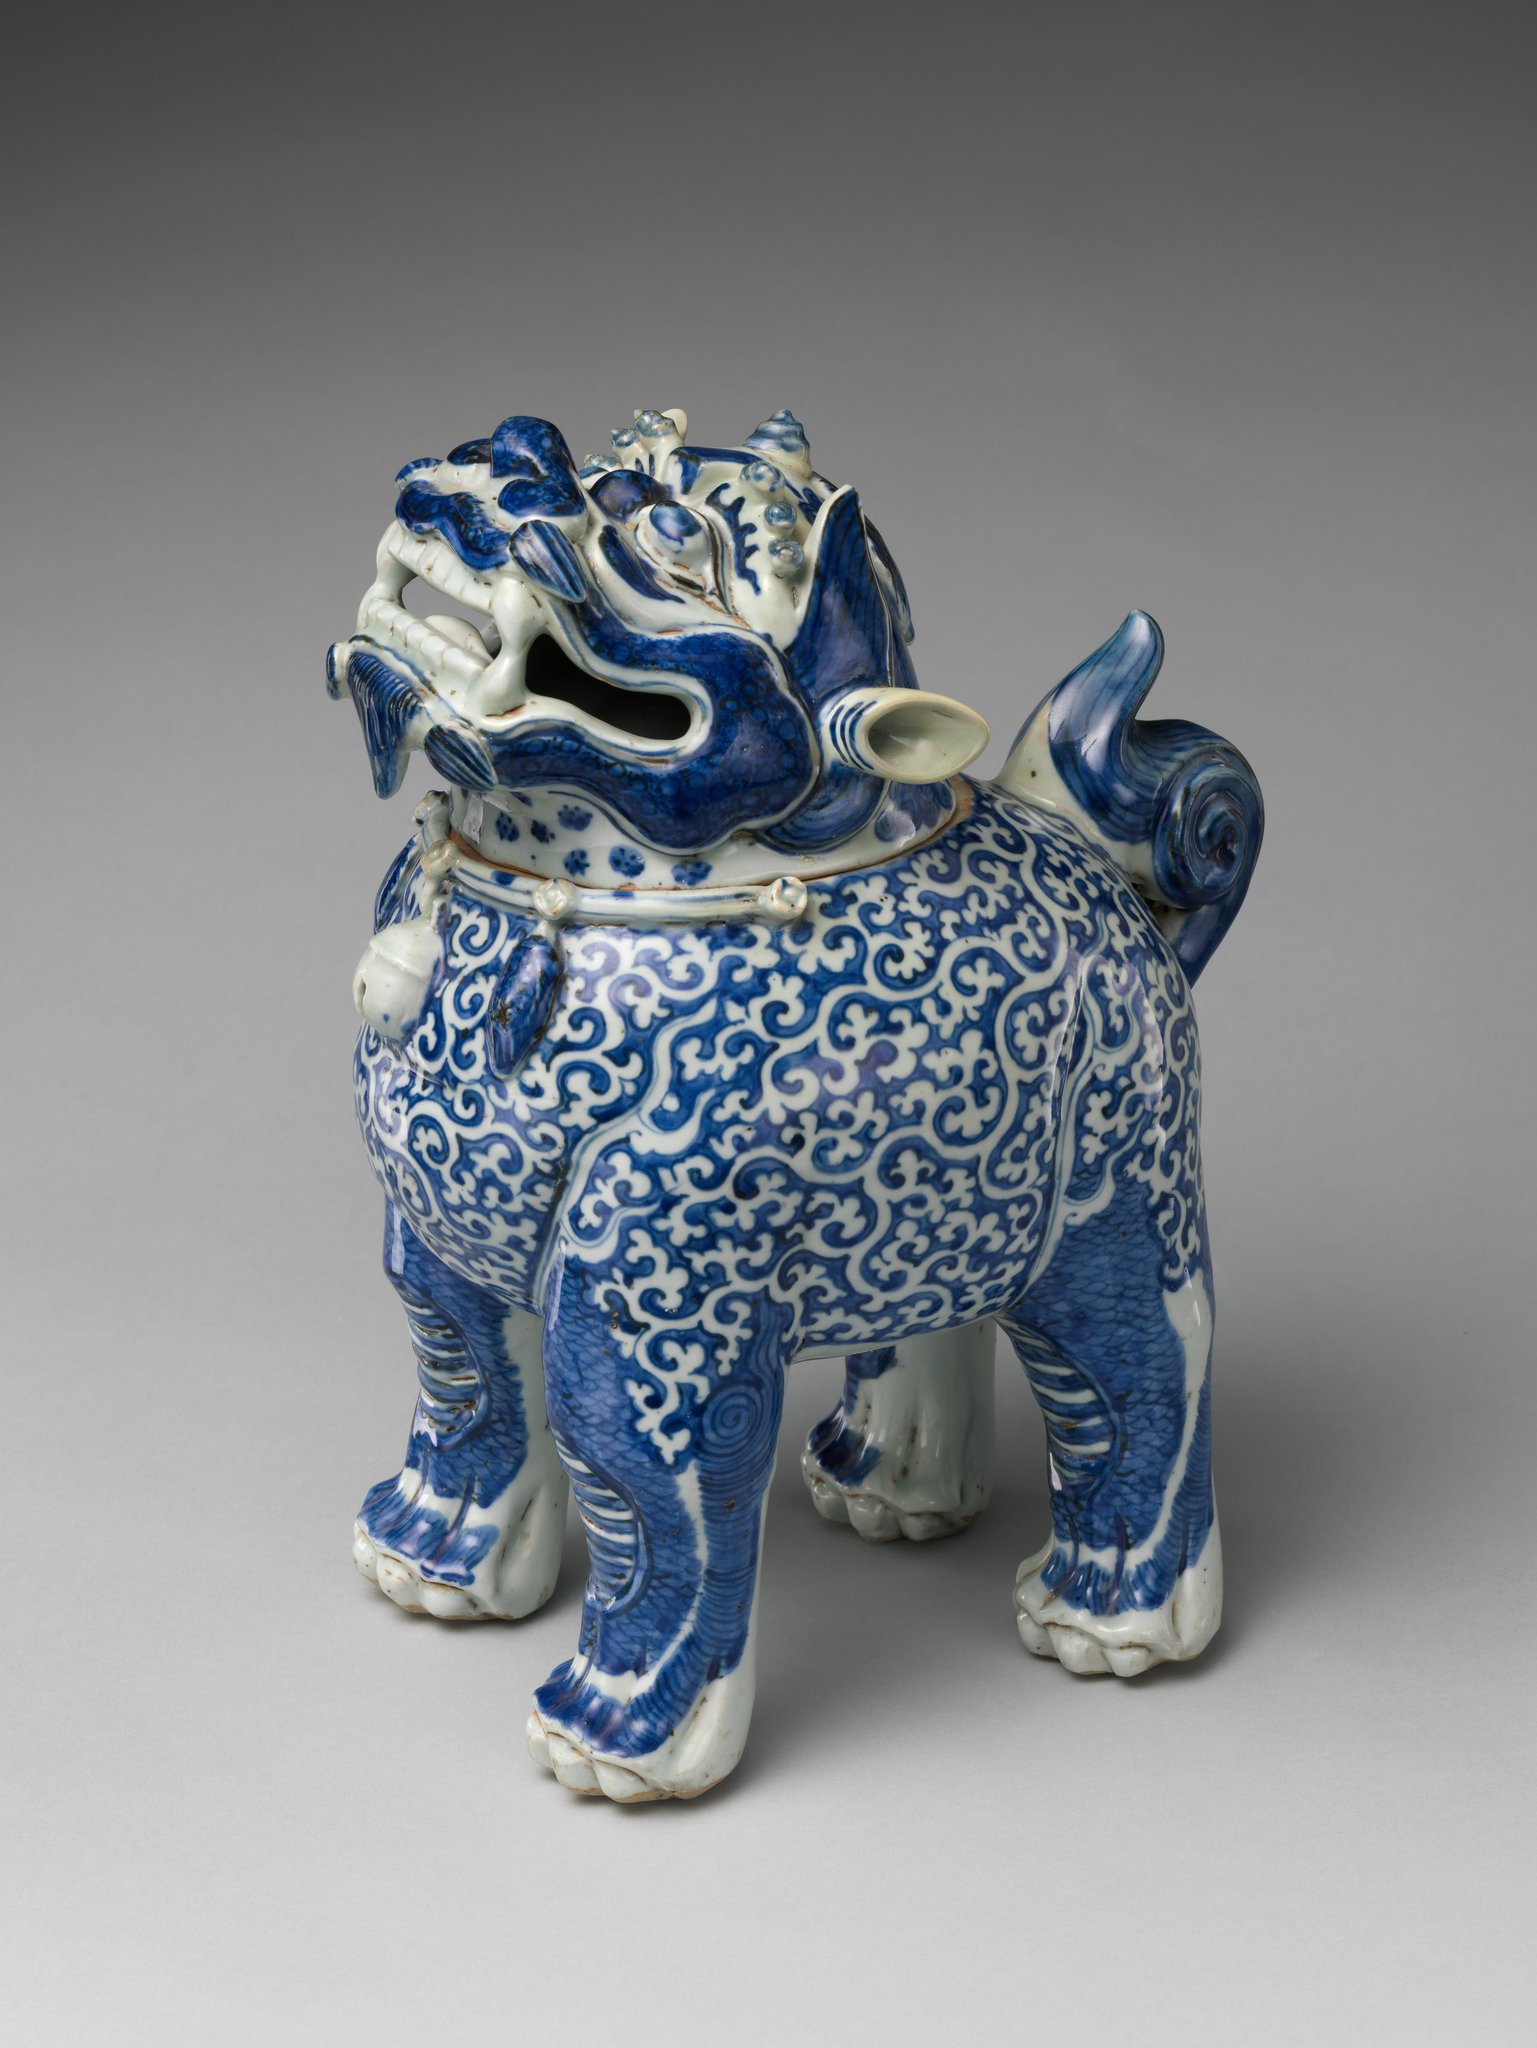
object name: cenert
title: Censer in the form of a mythical beast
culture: chinese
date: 1601-1633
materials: porcelain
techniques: painting, underglaze